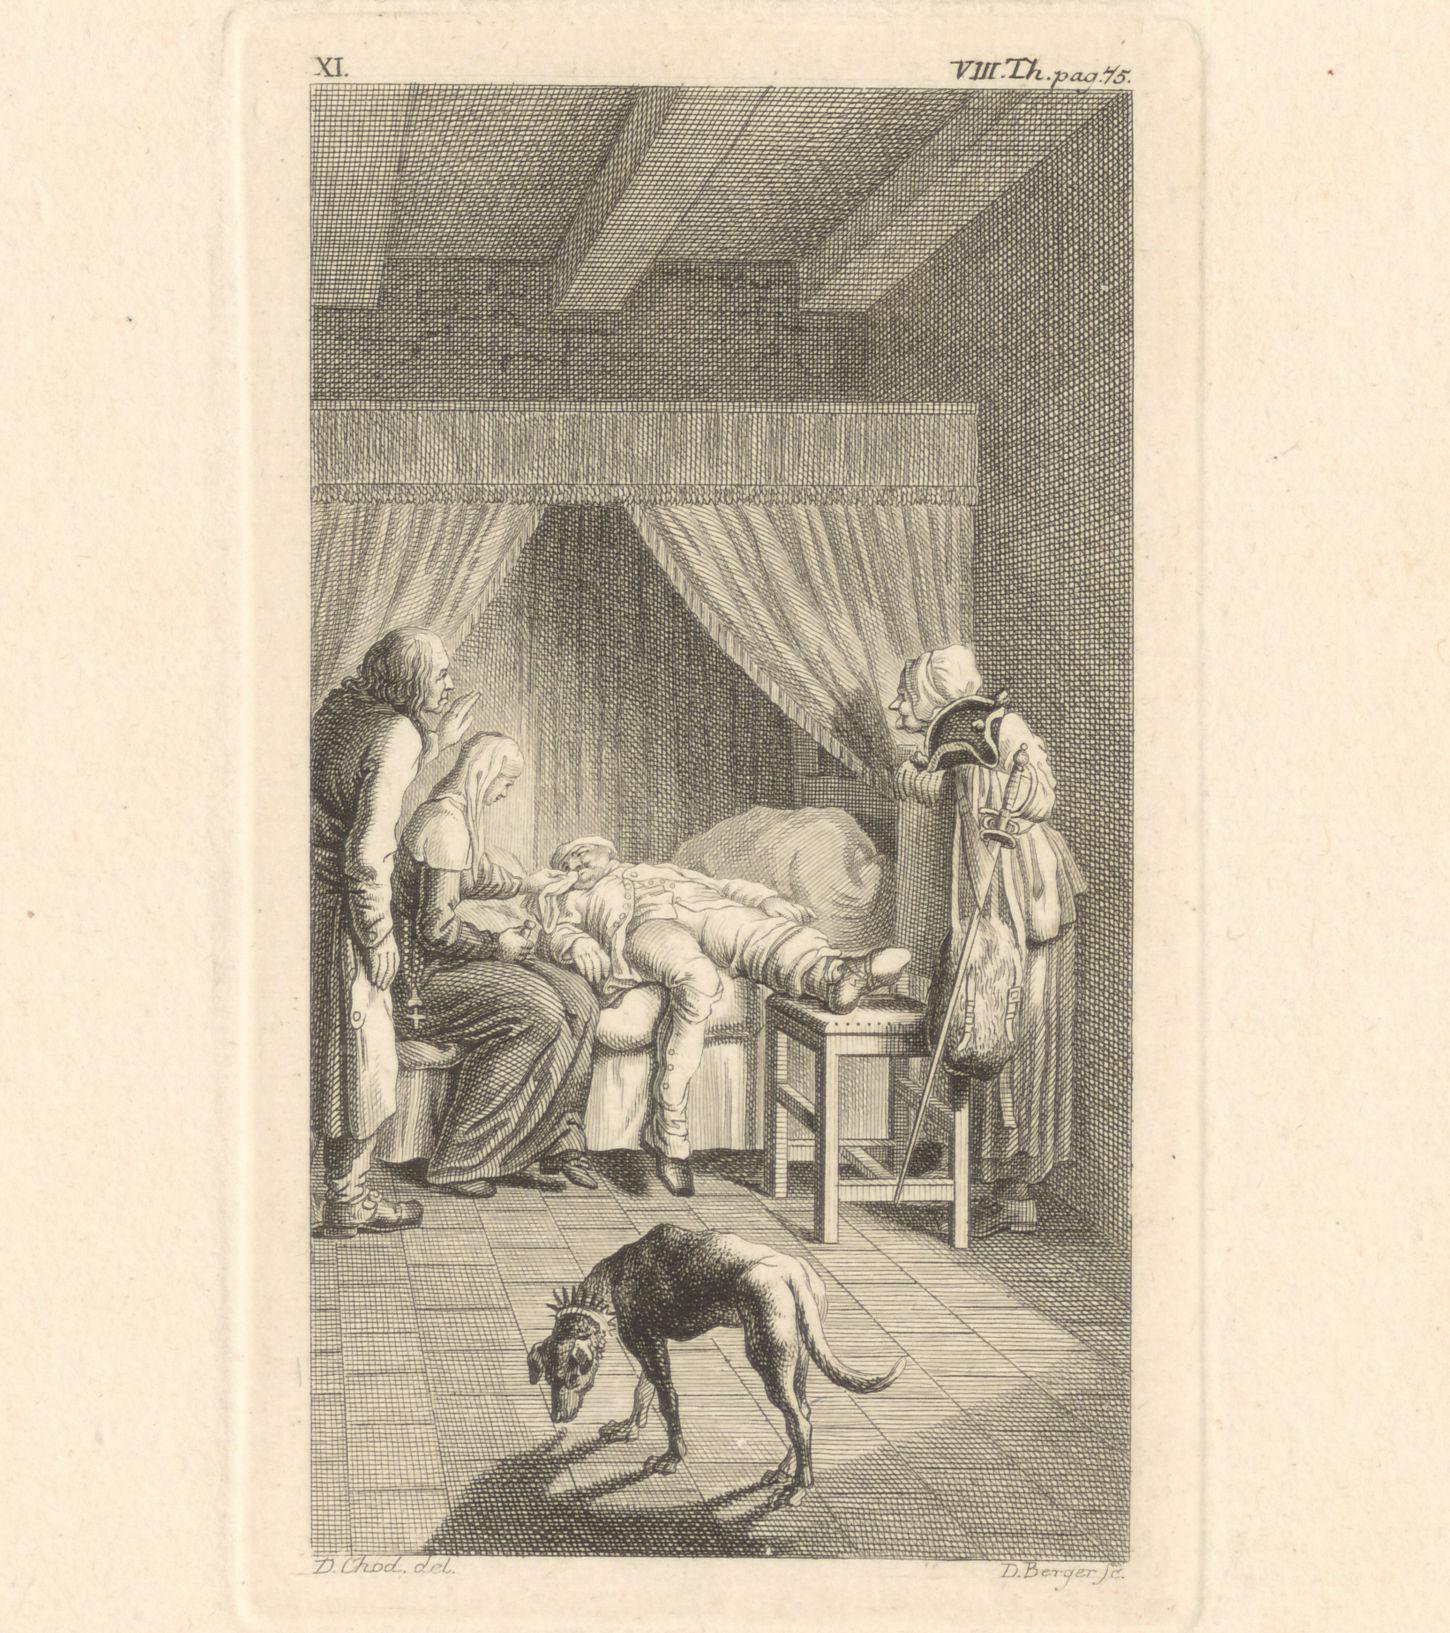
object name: print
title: Korporaal Trim wordt door een non verpleegd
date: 1778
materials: paper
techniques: etching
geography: berlin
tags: london, nun(s), literary characters and objects, nursing, tending the sick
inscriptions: collector's mark: Lugt 240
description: Elfde prent uit de serie 'XII Kupfer zu den Leben und Meynungen Tristram Shandy's' gedrukt op kosten van de Berlijnse boekhandelaar Christian Friedrich Himburg in 1778. De illustraties volgen een eerder verschenen tekstuitgave: [Stern, Laurence]. Tristram Schandis Leben und Meynungen [uit het Duits vertaald door] Johann Joachim Christoph Bode. 9 dln. Hamburg: Carl Ernst Bohn te Hamburg, 1776.